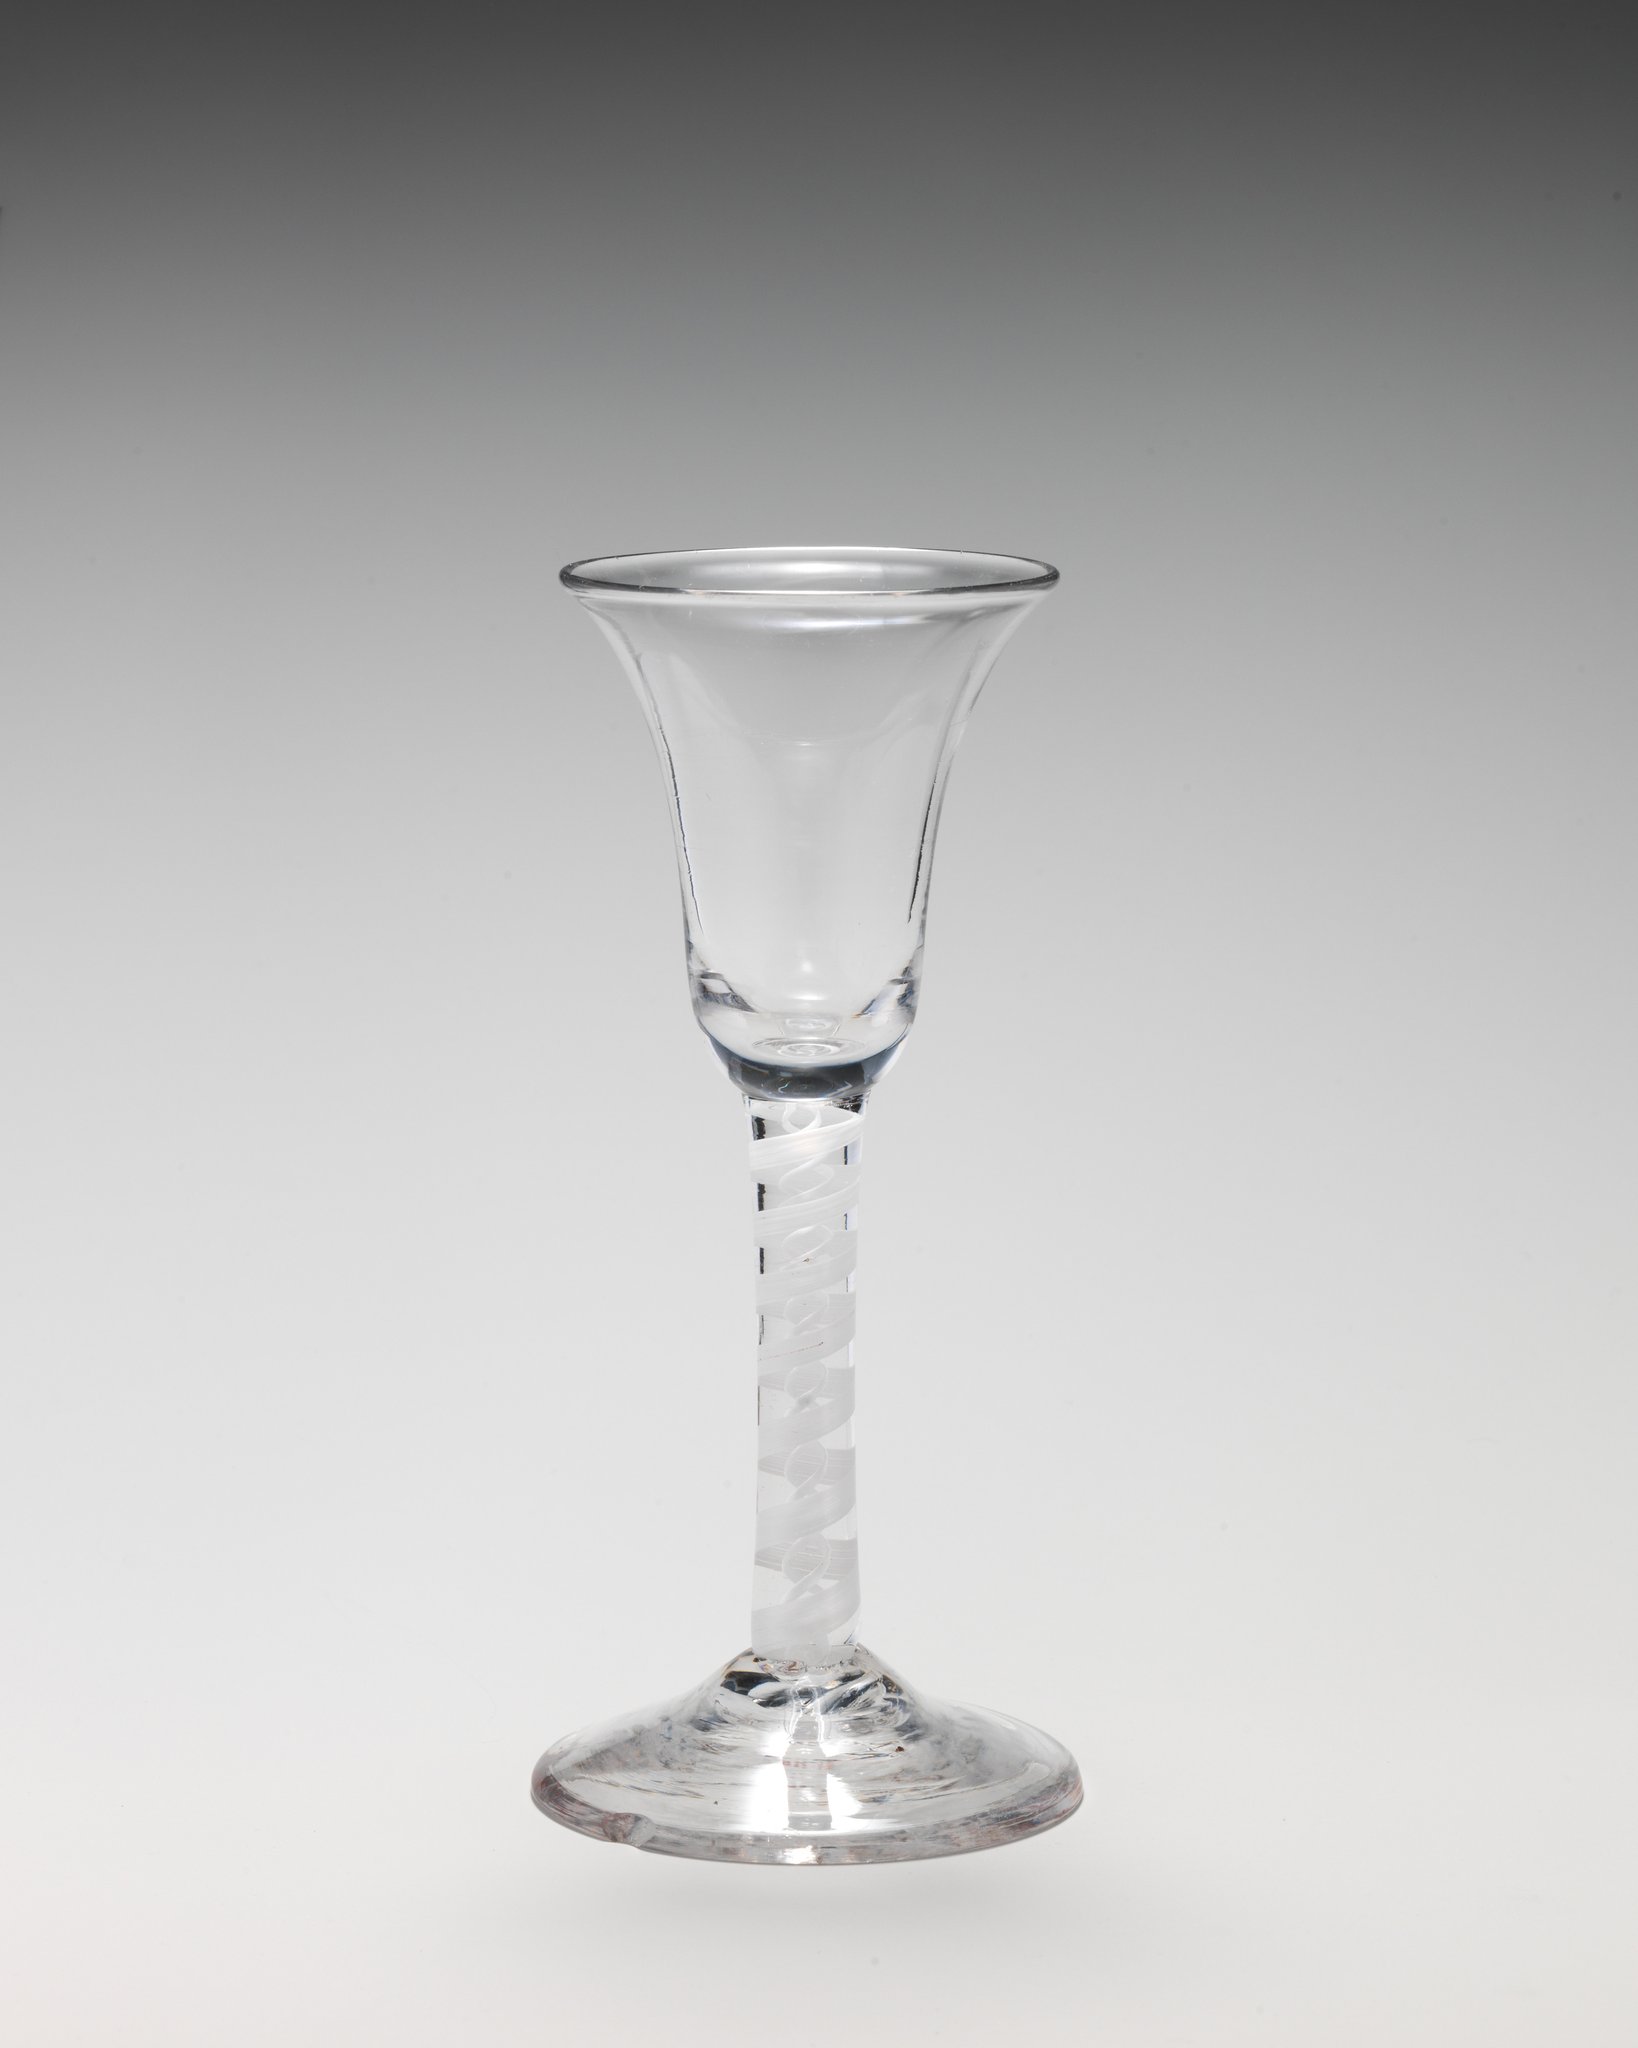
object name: wineglass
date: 1750-1800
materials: glass